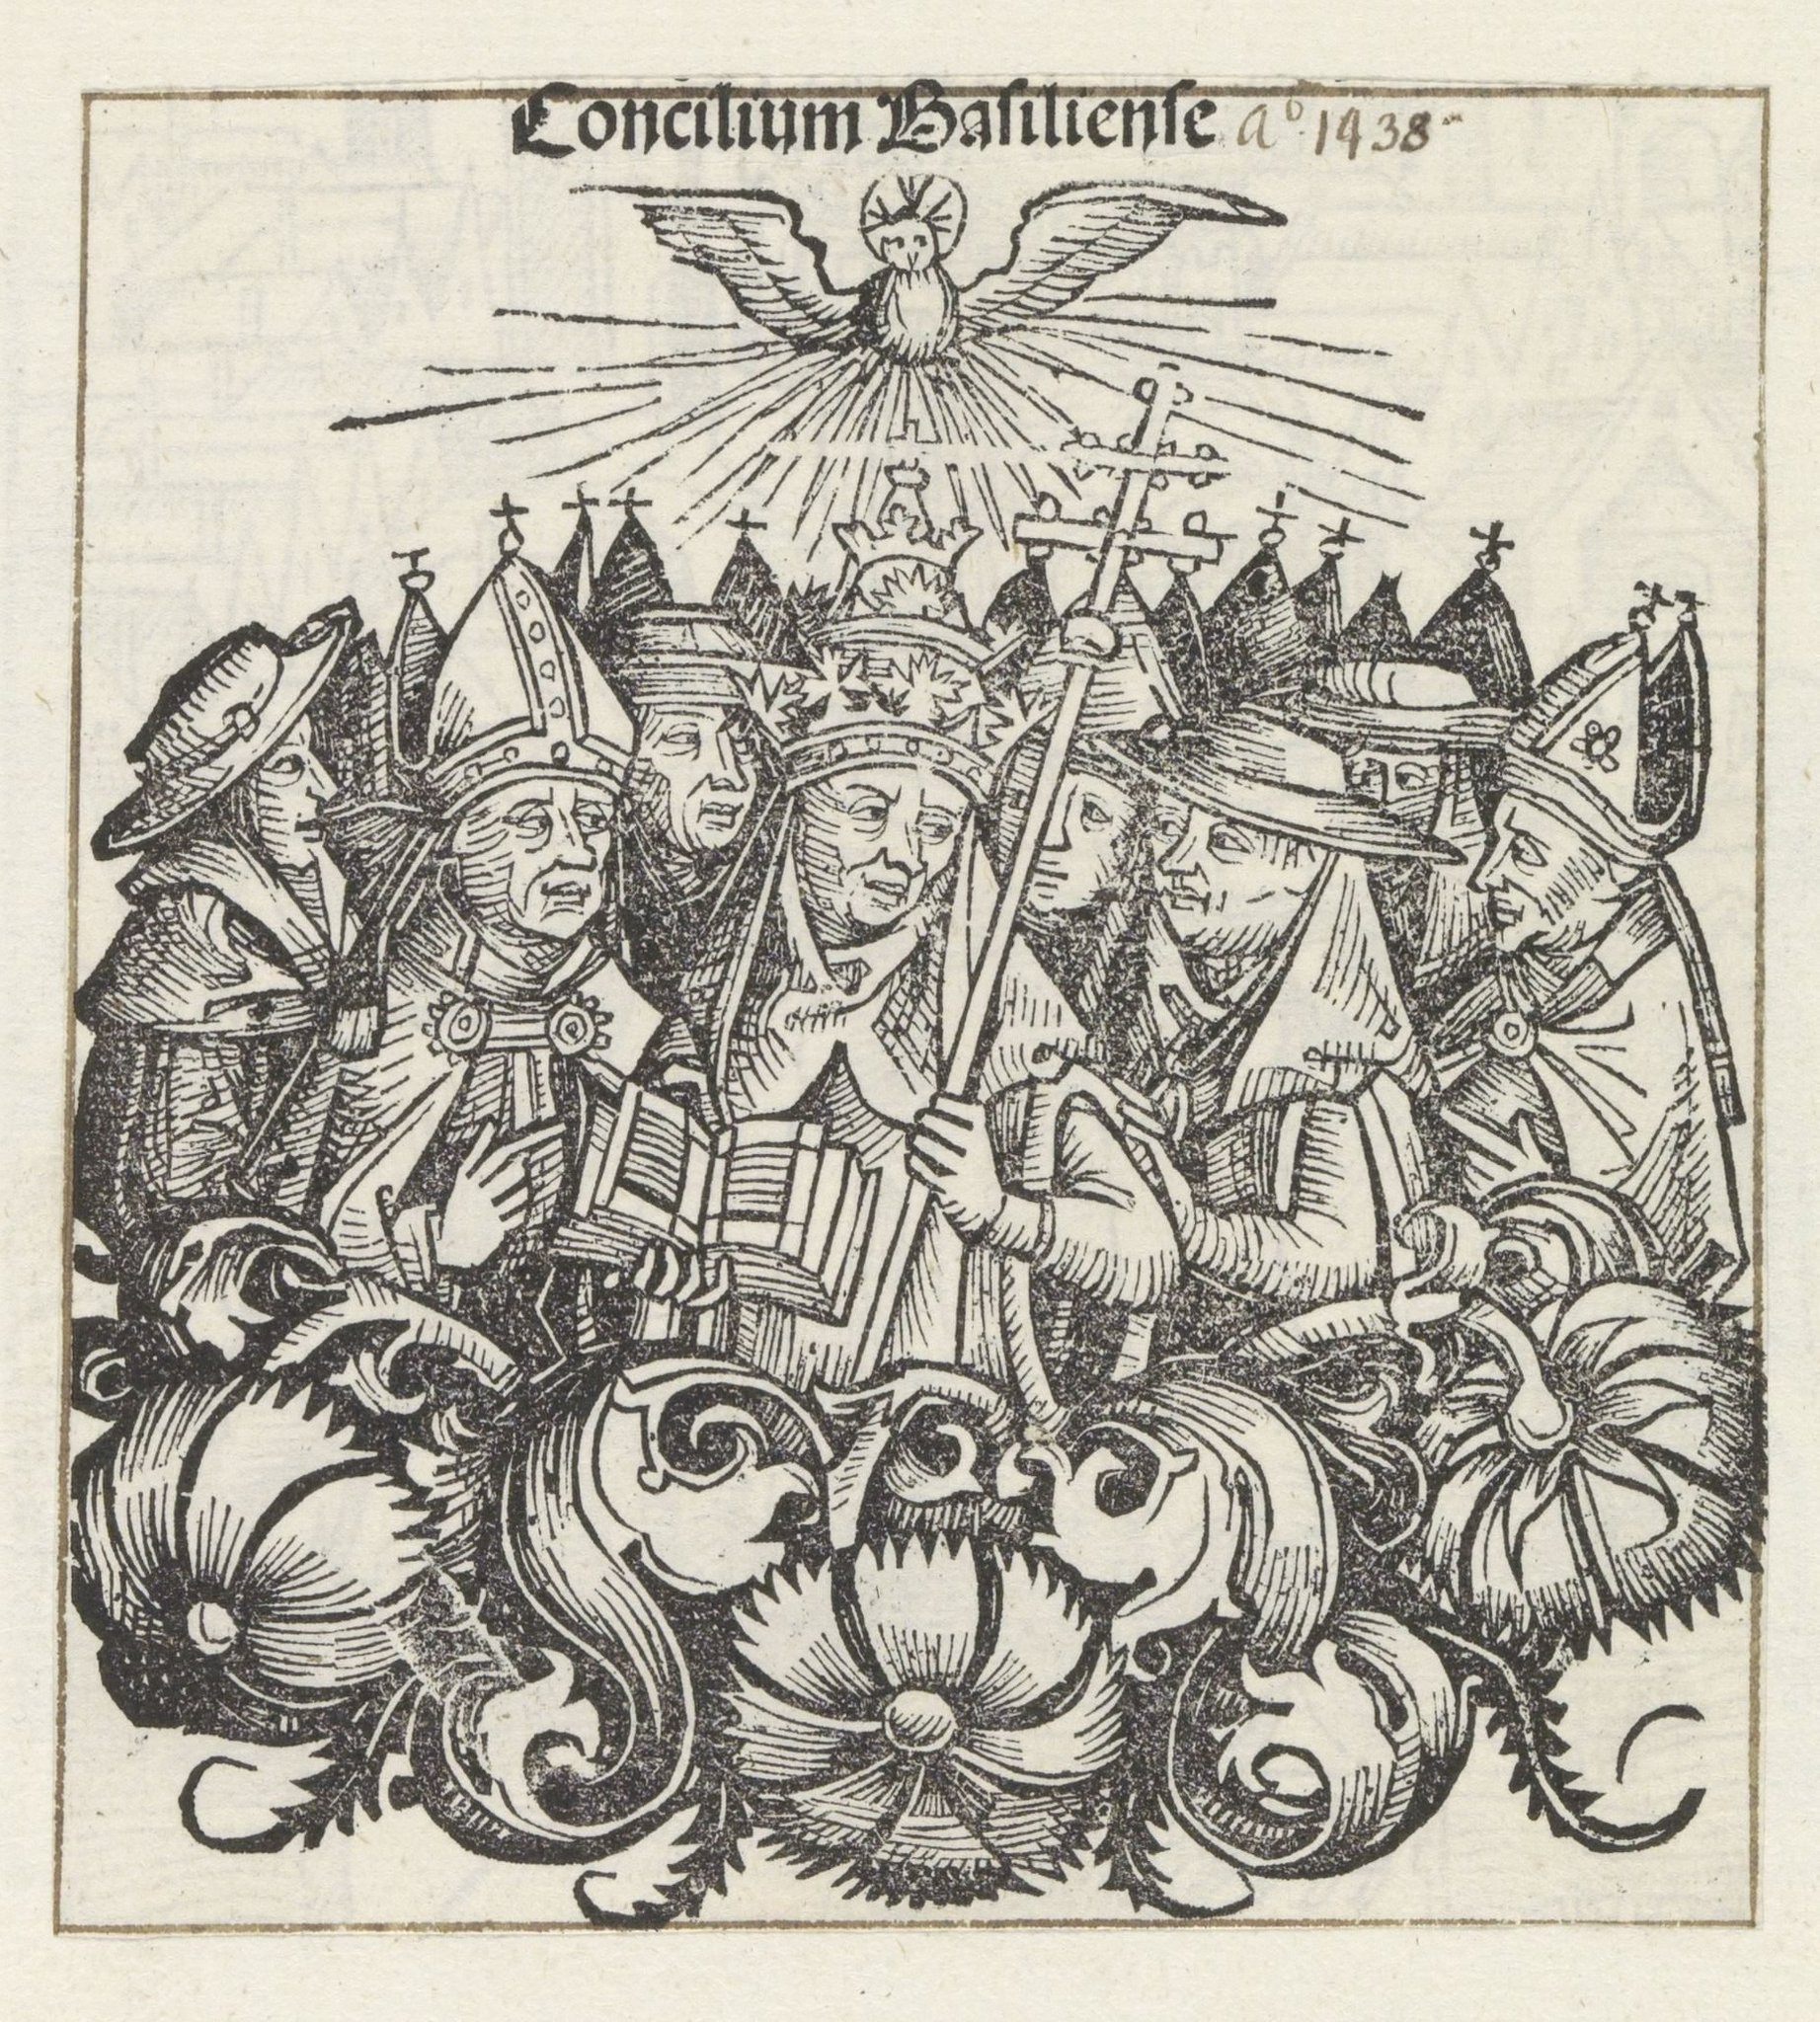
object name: album leaf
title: Concilie van Bazel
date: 1493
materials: paper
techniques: letterpress printing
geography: nuremberg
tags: cardinal, council, synod ~ roman catholic church, pope, holy ghost represented as a dove (in flames)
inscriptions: inscription: ‘Ao 1438’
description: Een paus, bisschoppen en kardinalen op een wolk van bloemen en bladeren. De paus heeft een opengeslagen bijbel en een staf met dubbel kruis in zijn handen. Daarboven de Heilige Geest in de vorm van een duif. De prent maakt deel uit van een album.